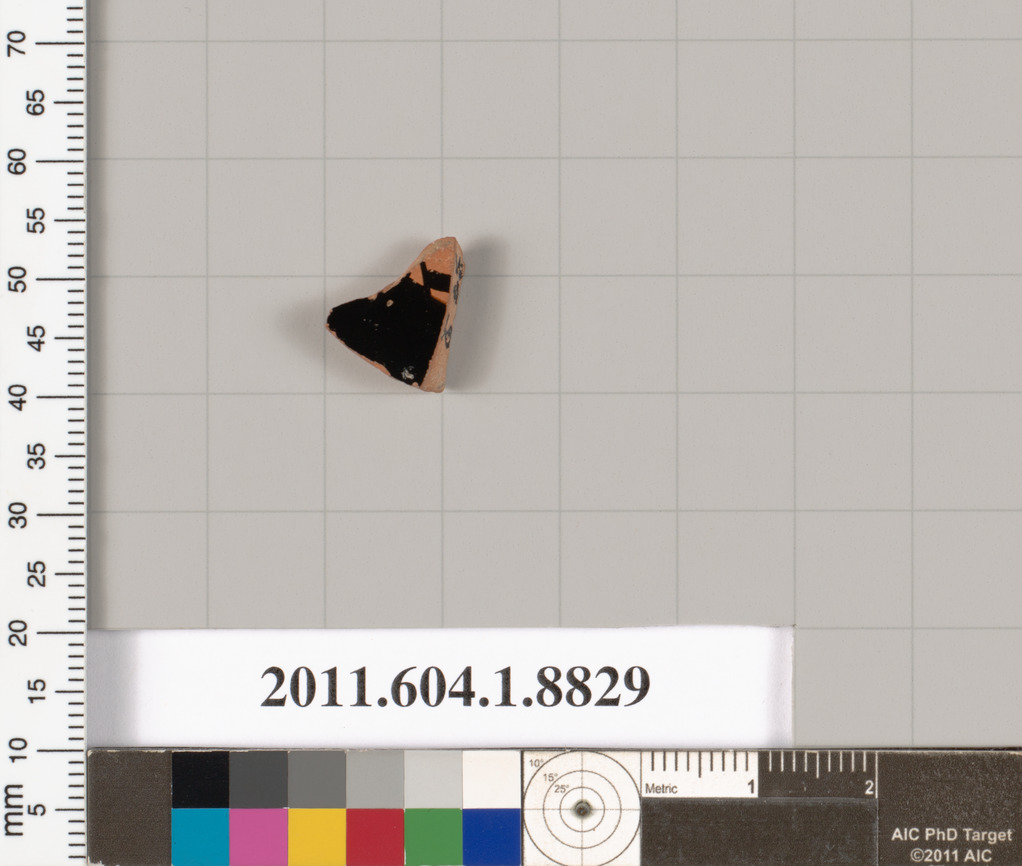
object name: kylix fragment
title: Terracotta fragment of a kylix (drinking cup)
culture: greek, attic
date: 490-480 BCE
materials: terracotta